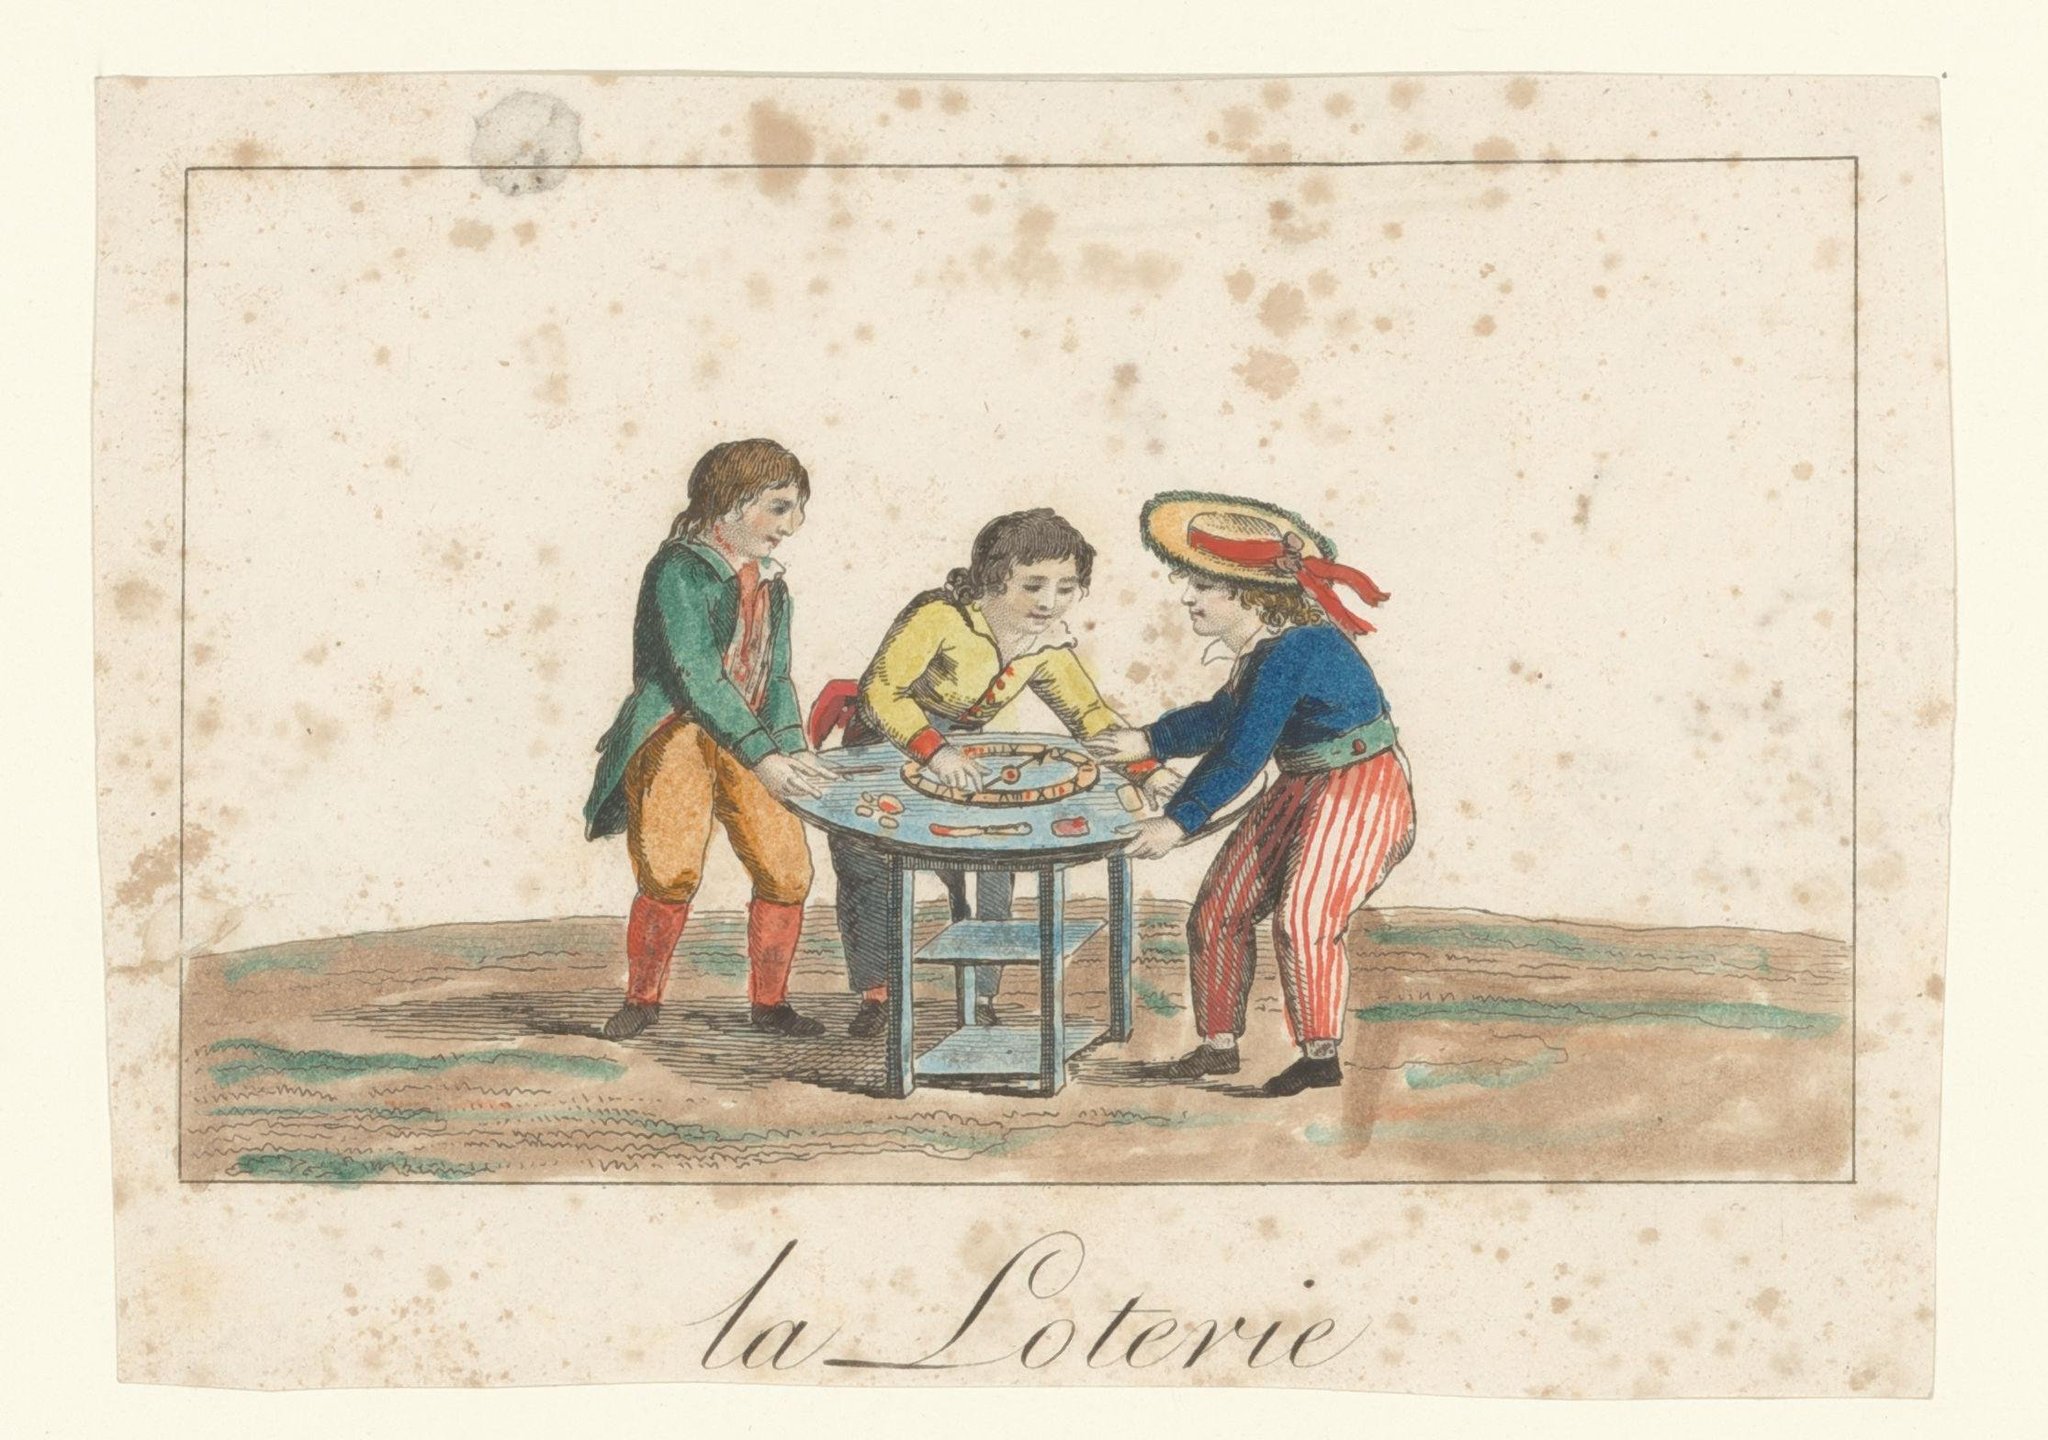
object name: print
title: Kinderen spelen een loterijspel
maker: Anonymous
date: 1800-1899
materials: paper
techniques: etching, hand coloring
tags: raffle, lottery, children's games and plays, child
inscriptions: stamp, collector's mark: Lugt 1641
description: Onderwerpsrubrieken binnen de Atlas Zeden en Gewoonten: Zeden en Gewoonten in Engeren Zin, Des menschen beging, midden en einde, Kinderleven – Kinderspel en Kinderprenten.